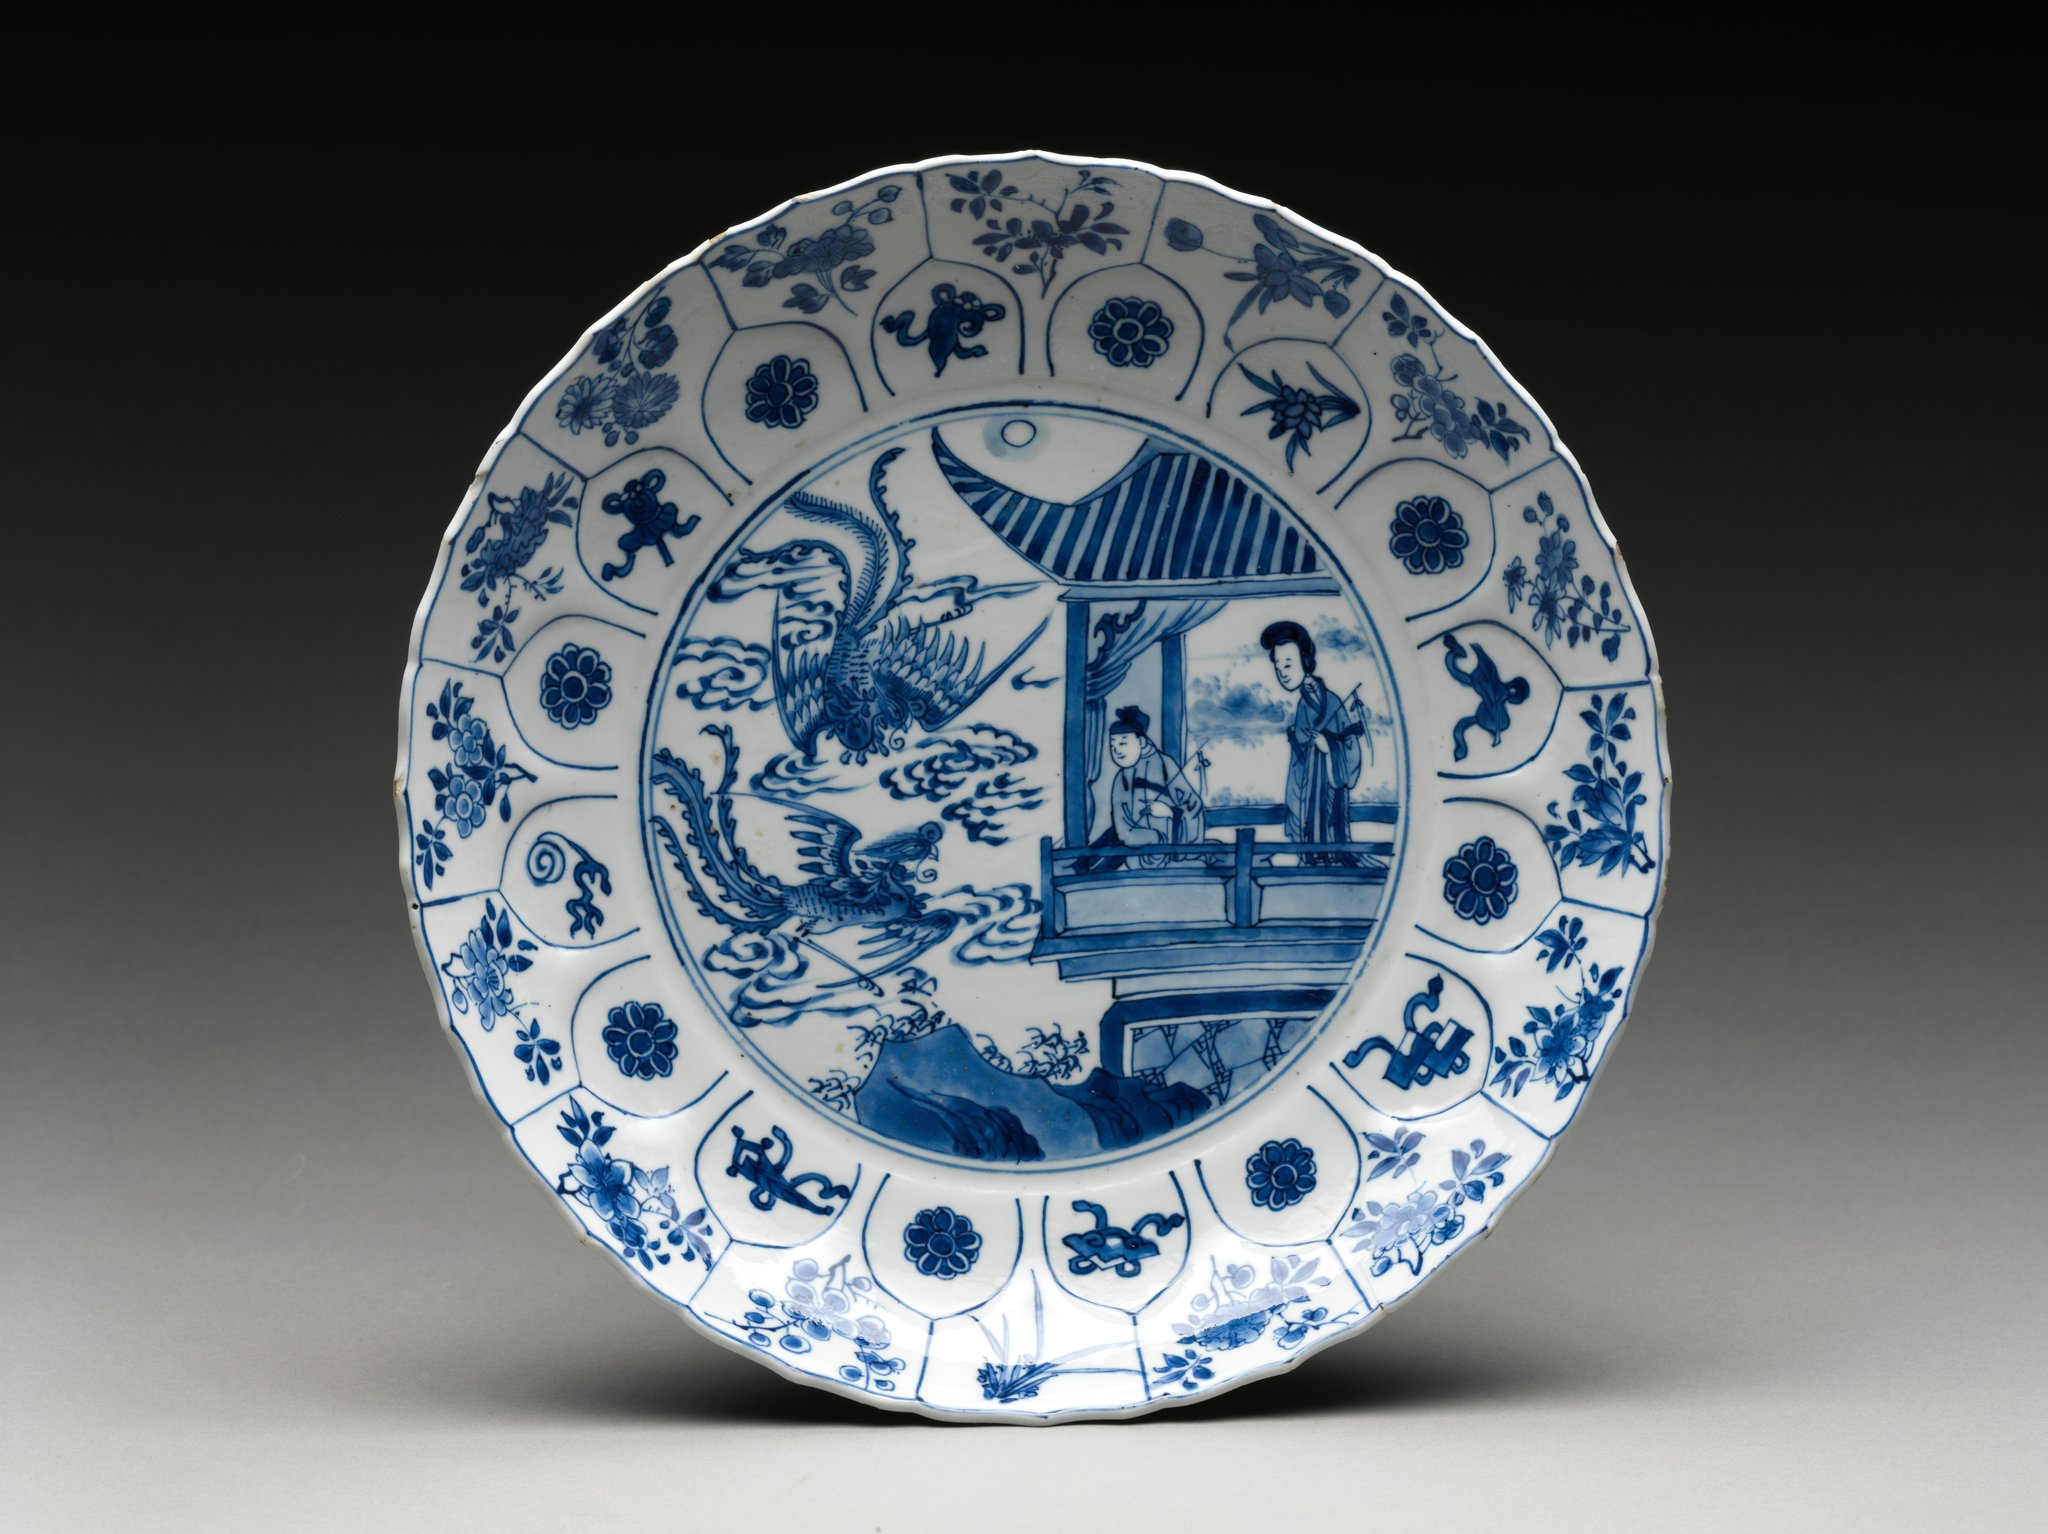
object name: dish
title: Dish with a couple and phoenixes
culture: chinese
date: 1644-1911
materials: cobalt, porcelain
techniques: painting, underglaze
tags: couples,men,women,phoenix,flowers